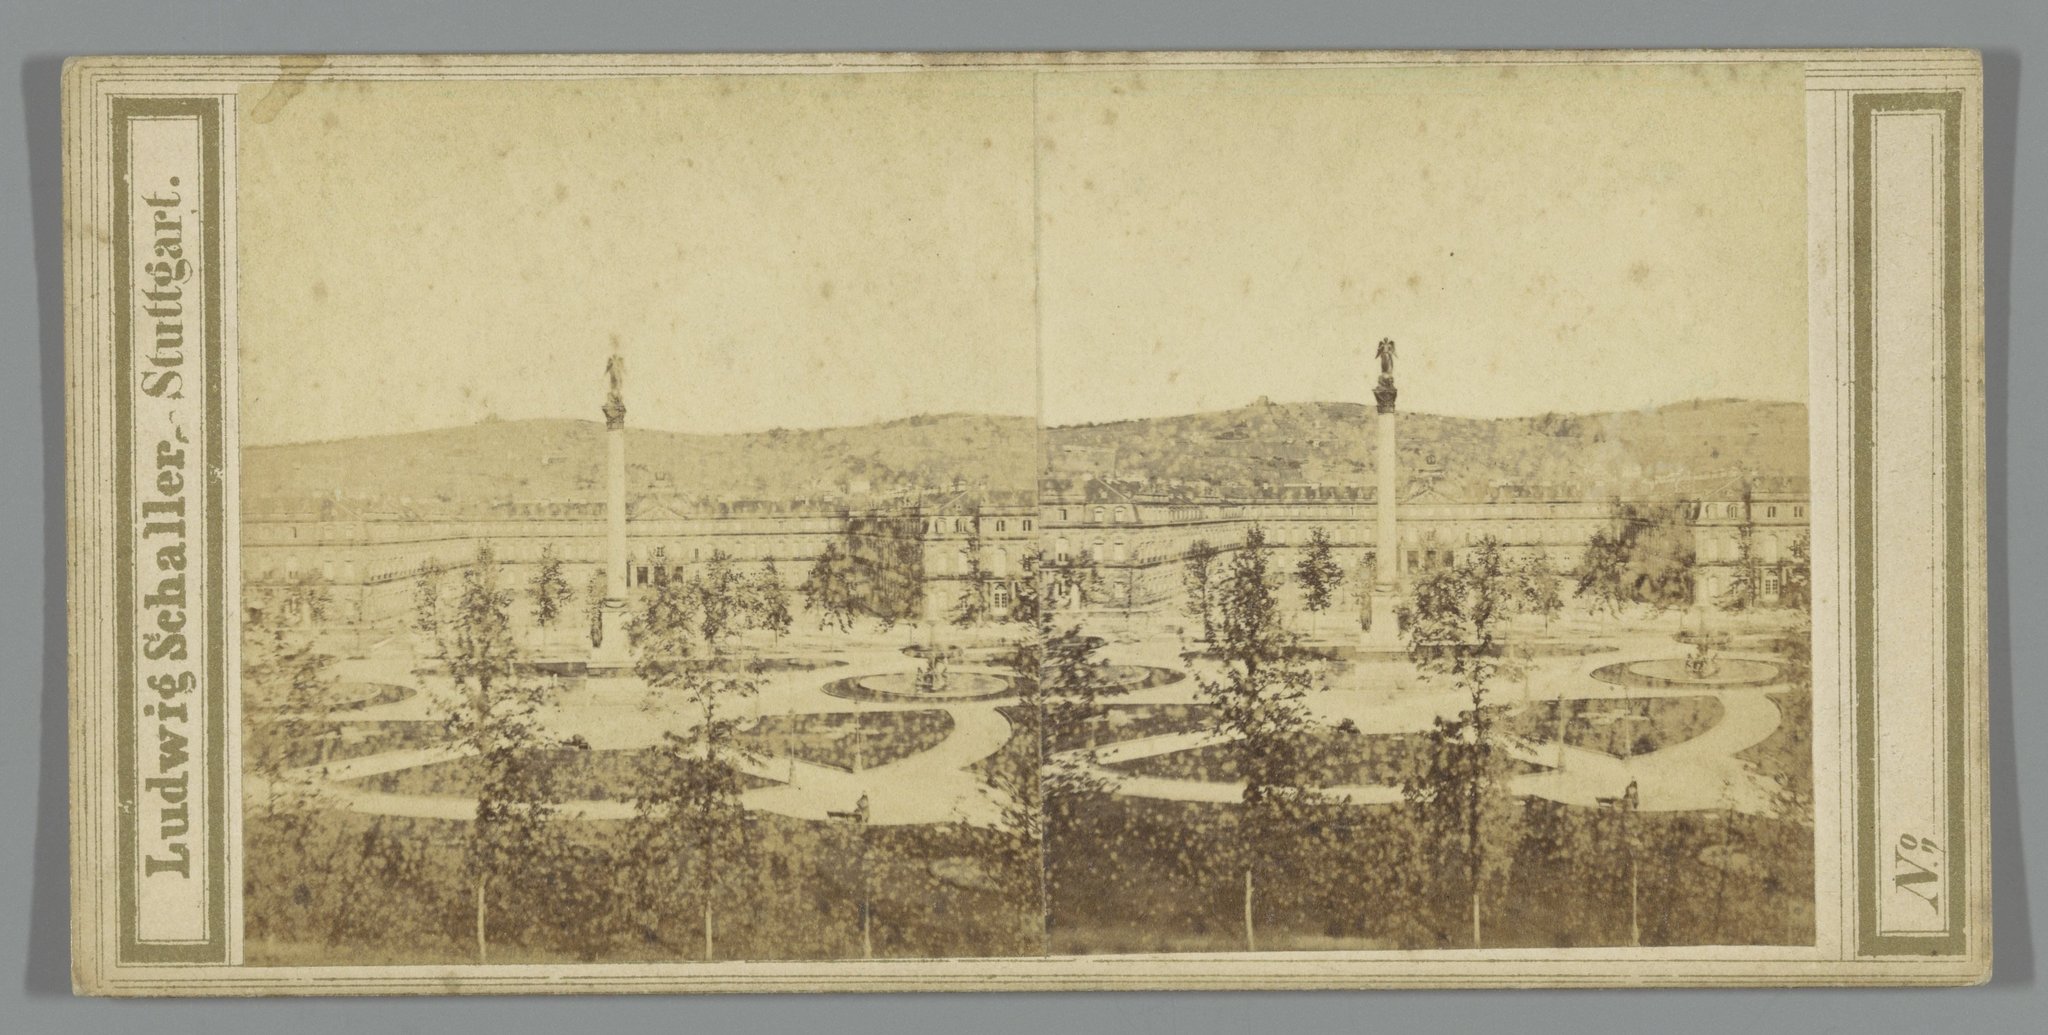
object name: stereograph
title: Exterieur van het Neues Schloss te Stuttgart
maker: ludwig schaller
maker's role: publisher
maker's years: 1824-1871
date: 1860-1867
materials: cardboard, photographic support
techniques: albumen print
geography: stuttgart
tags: column, pillar ~ architecture, castle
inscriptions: inscription: ‘Het Koninglijke Paleis te Stuttgart’